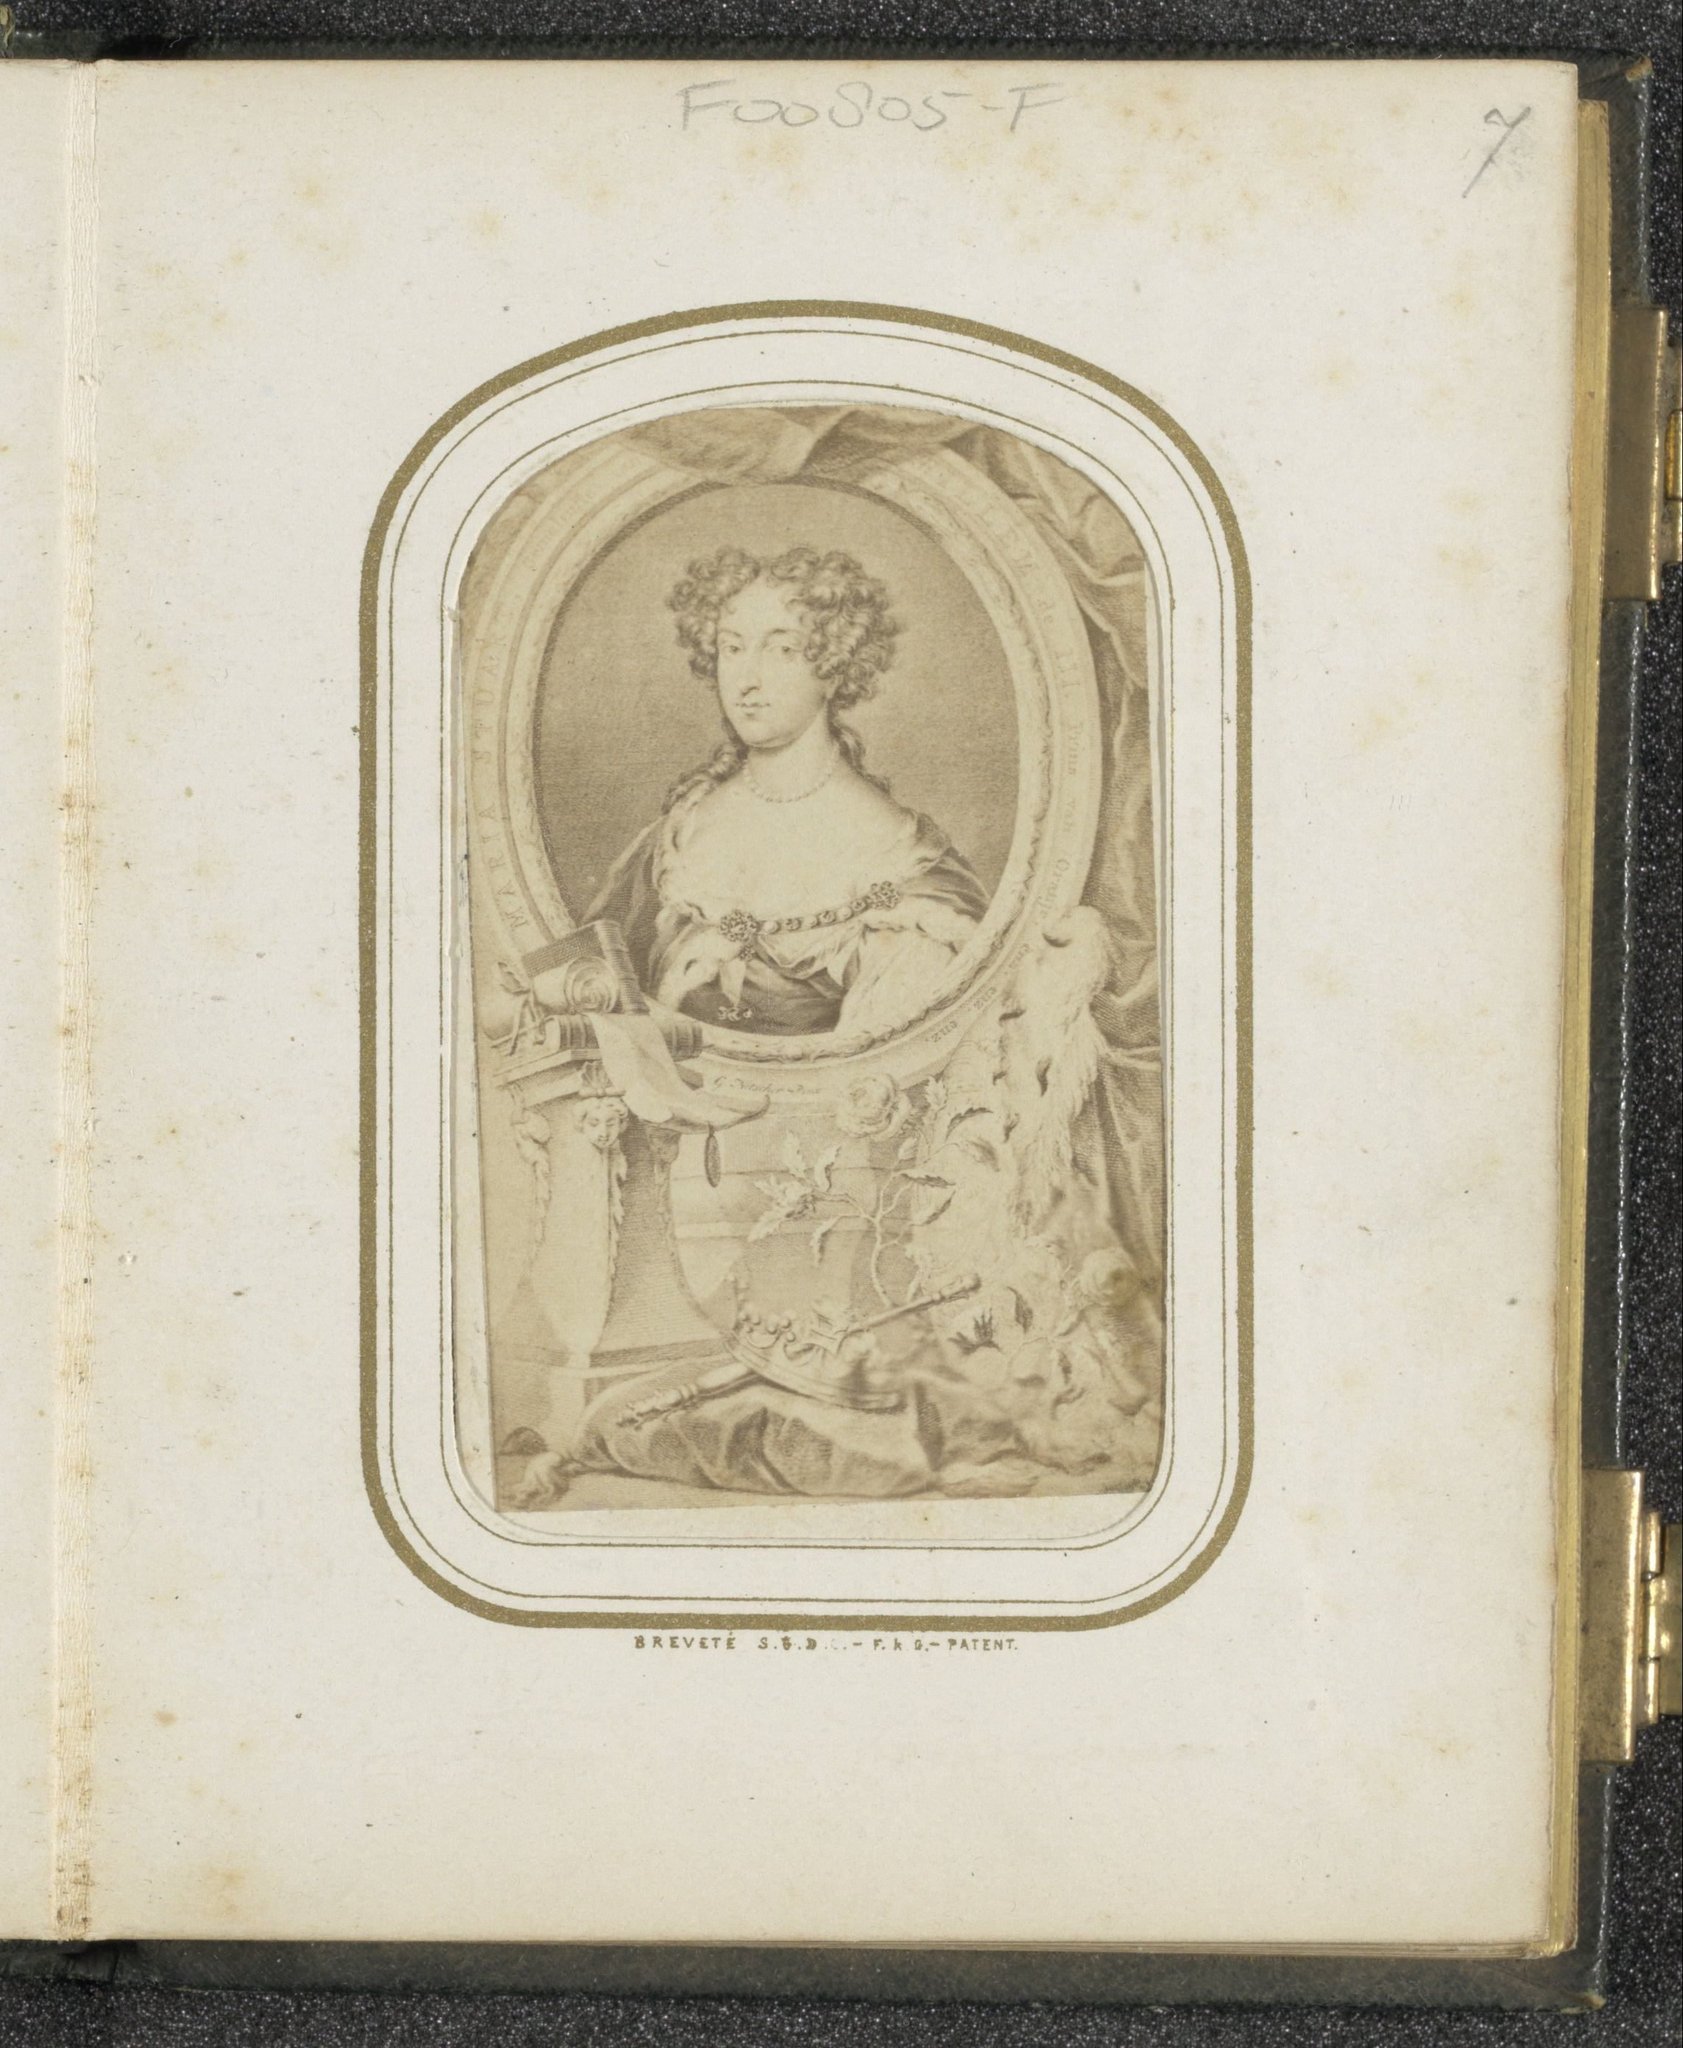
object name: carte de visite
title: Fotoreproductie van (vermoedelijk) een prent van Maria II Stuart, echtgenote van prins Willem III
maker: Anonymous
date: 1860-1880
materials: cardboard, paper, photographic support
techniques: albumen print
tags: london, maria ii stuart (koningin van engeland, schotland en ierland), historical persons, ruler, sovereign - bb - female ruler, styles of hairdress - aa - ~ women, dress, gown, necklace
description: Onderdeel van Fotoalbum met 29 foto's van Nederlandse vorsten.